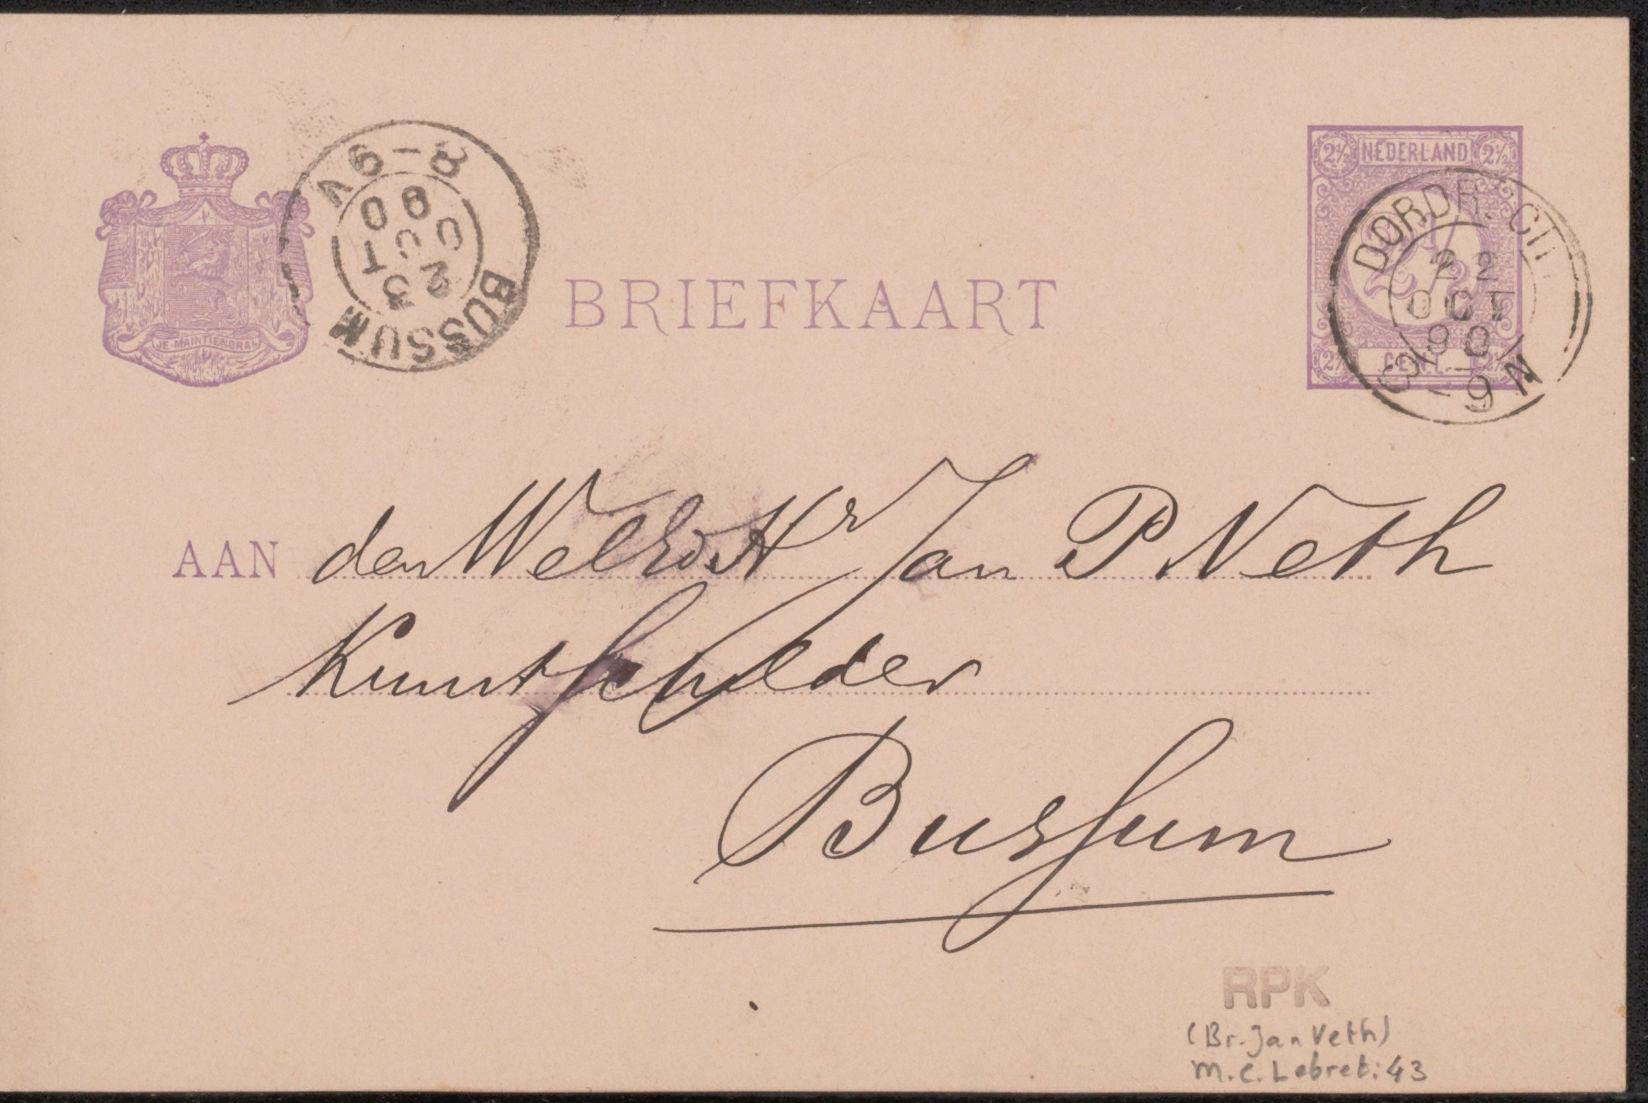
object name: postcard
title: Briefkaart aan Jan Veth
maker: martinus cornelis lebret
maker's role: verzamelaar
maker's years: 1833-1894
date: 1890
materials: cardboard, ink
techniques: pen, writing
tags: amsterdam, painter, print maker, draughtsman, designer, jan veth, belgium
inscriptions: collector's mark: ‘RPK’